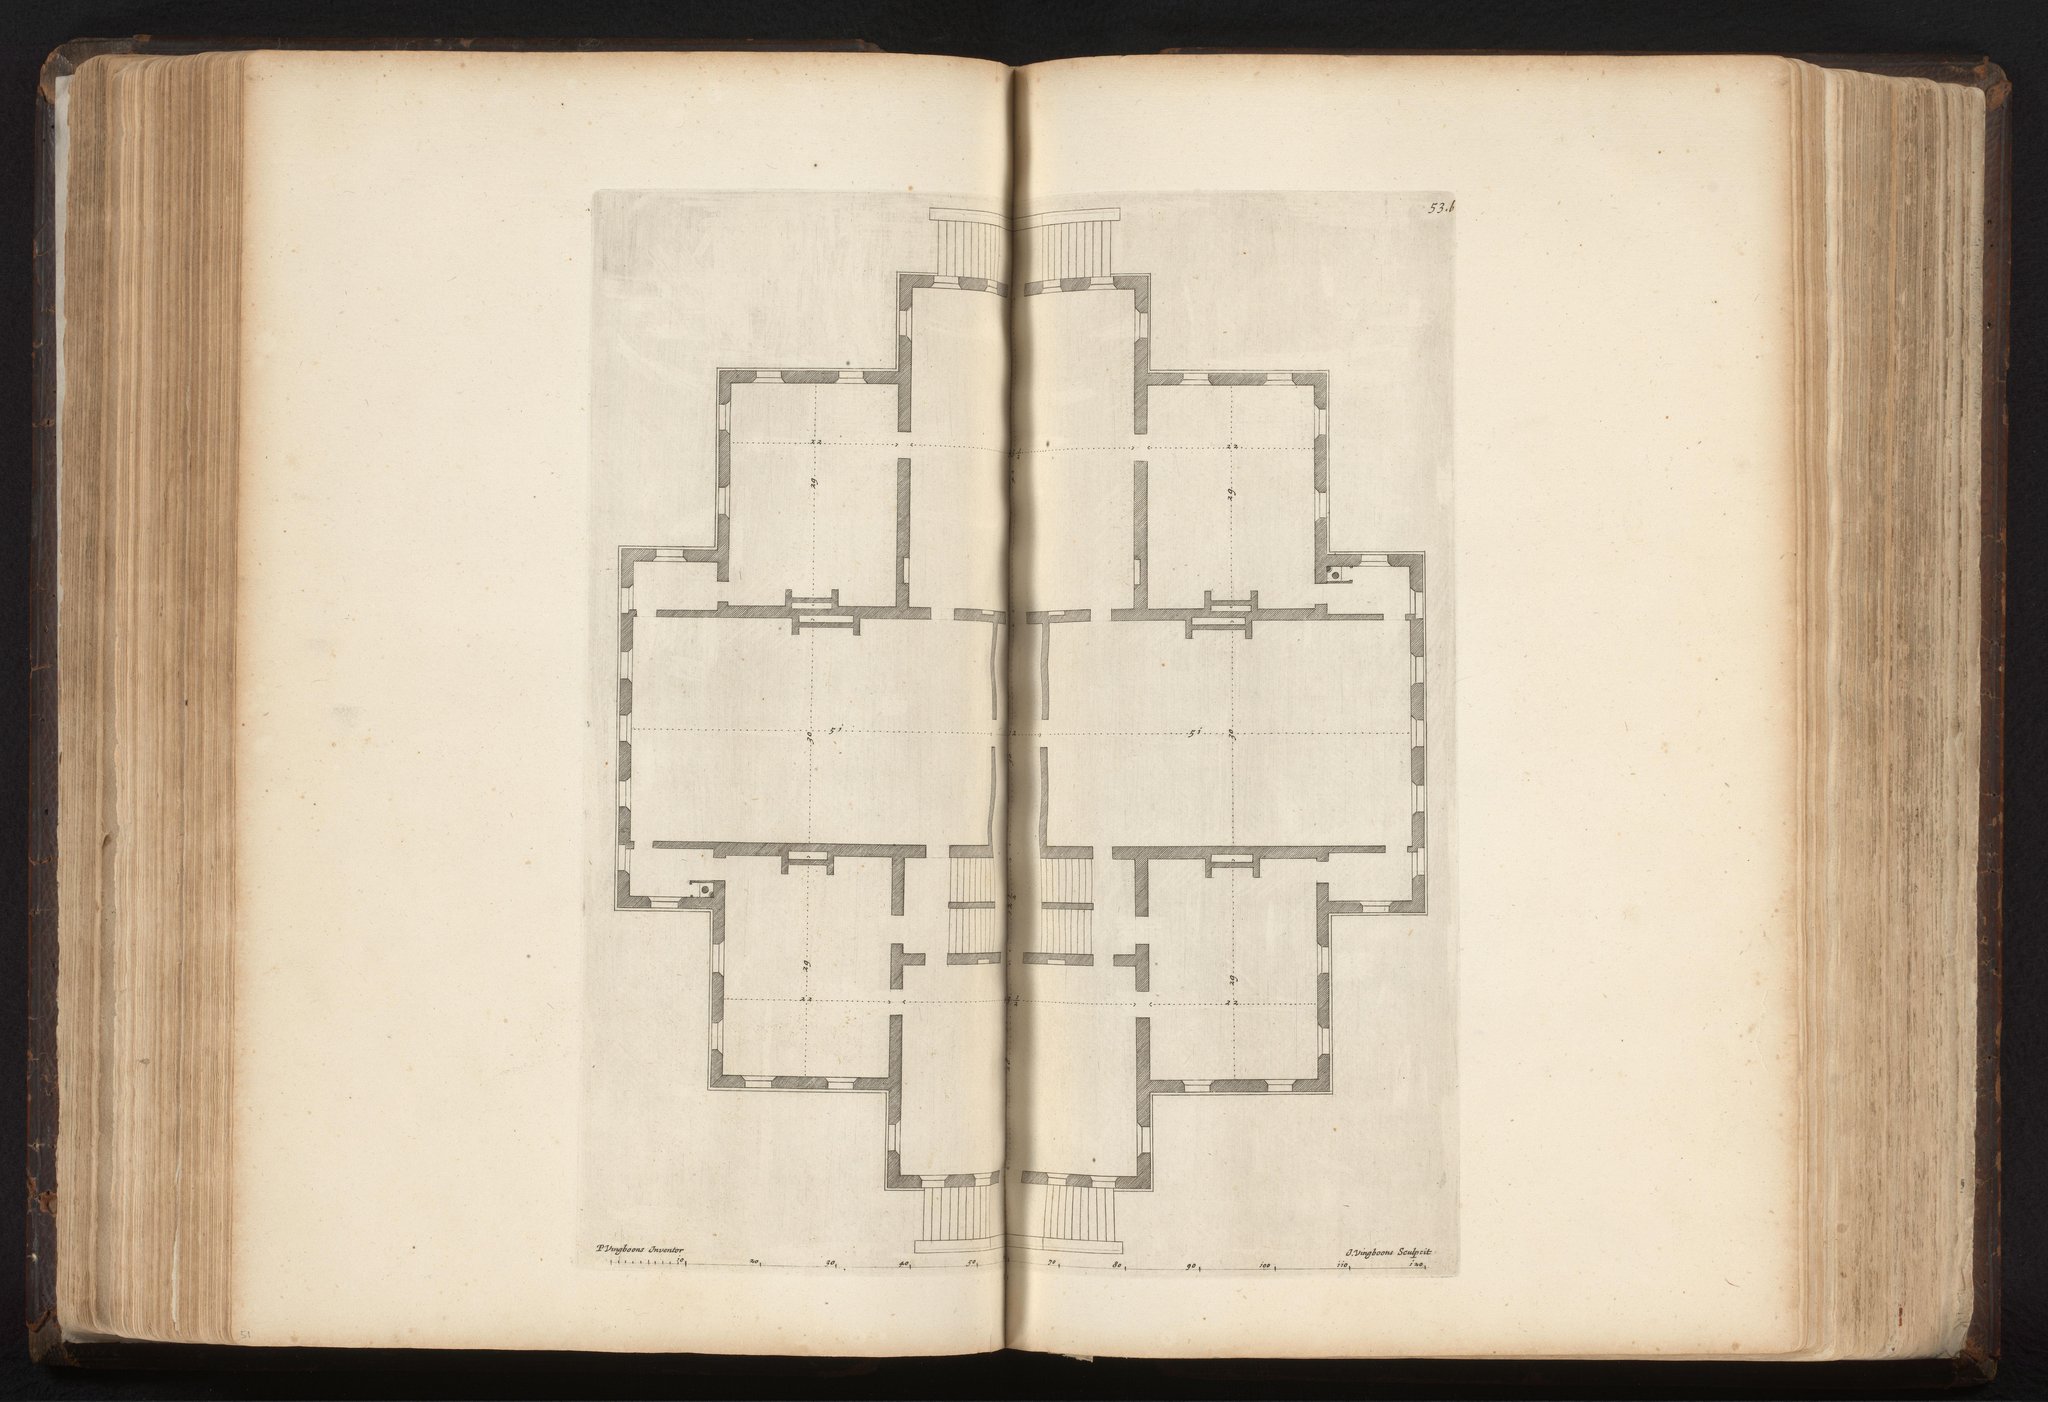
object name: print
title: Plattegrond voor een landhuis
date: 1648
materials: paper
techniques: engraving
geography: amsterdam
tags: plan ~ architecture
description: Prent uit: Afbeelsels der voornaemste gebouwen uyt alle die Philips Vingboons geordineert heeft. Amsterdam: Philips en Johannes Vinckboons en Johannes Willemszoon Blaeu, 1648.